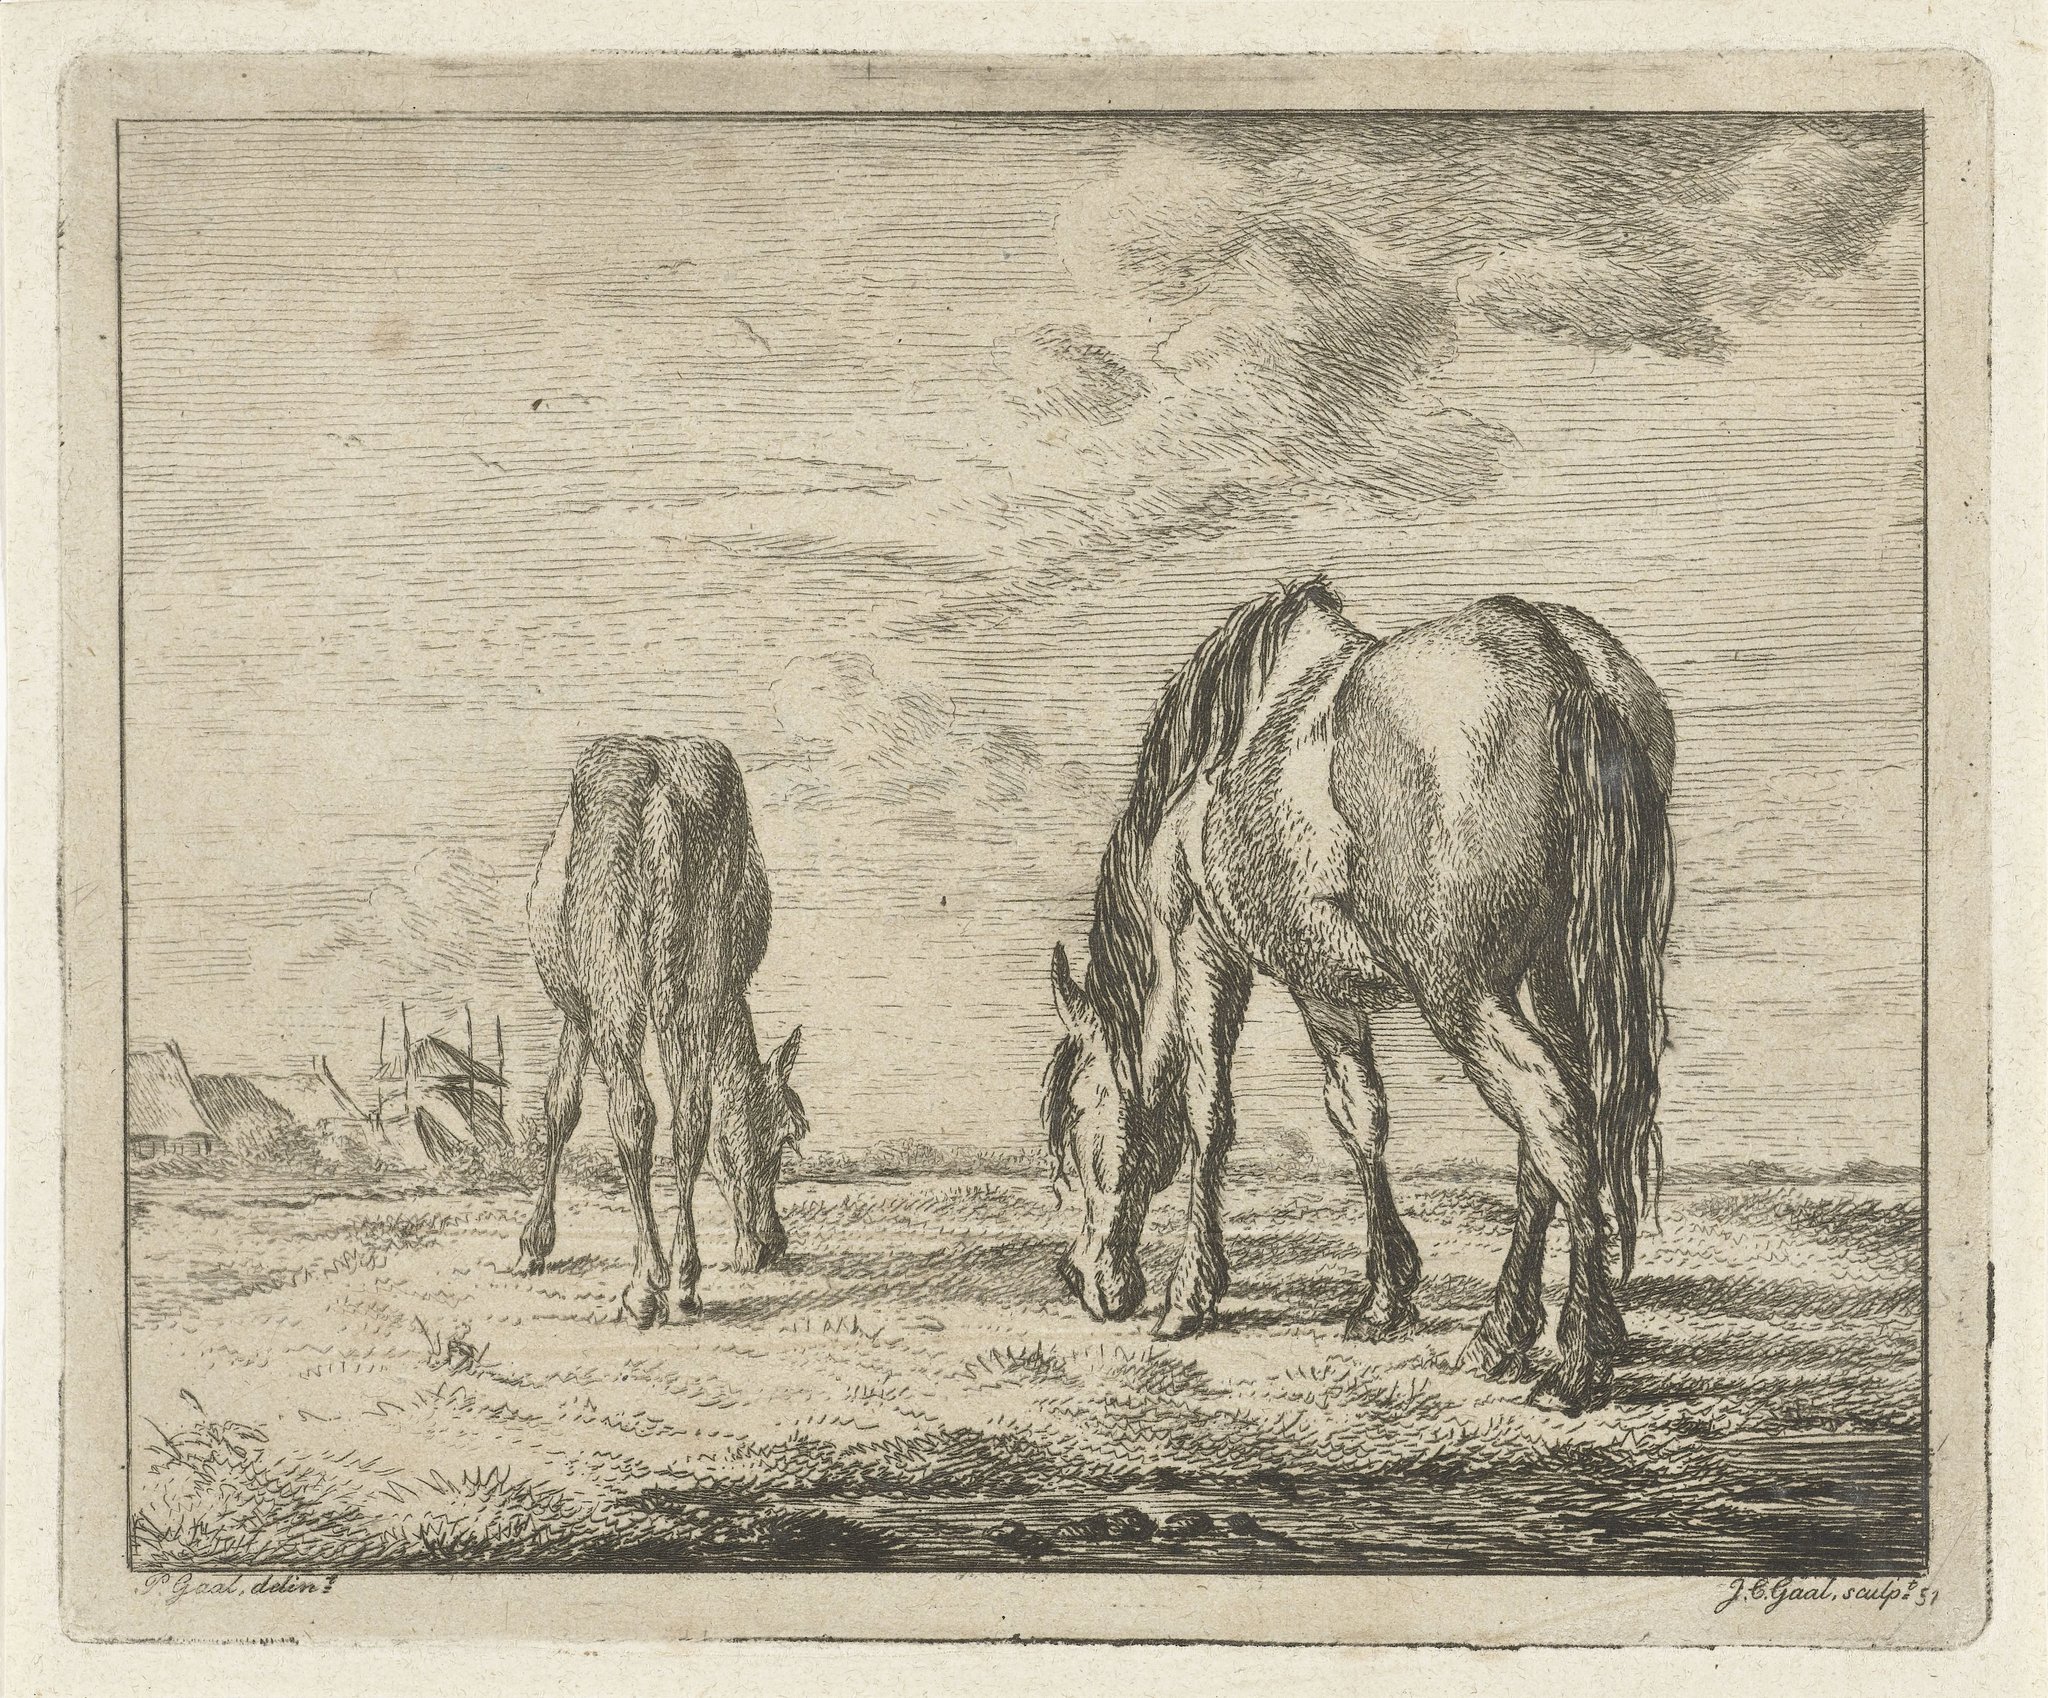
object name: print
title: Twee grazende paarden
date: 1851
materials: paper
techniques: etching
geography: netherlands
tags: horse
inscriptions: collector's mark: Lugt 2228